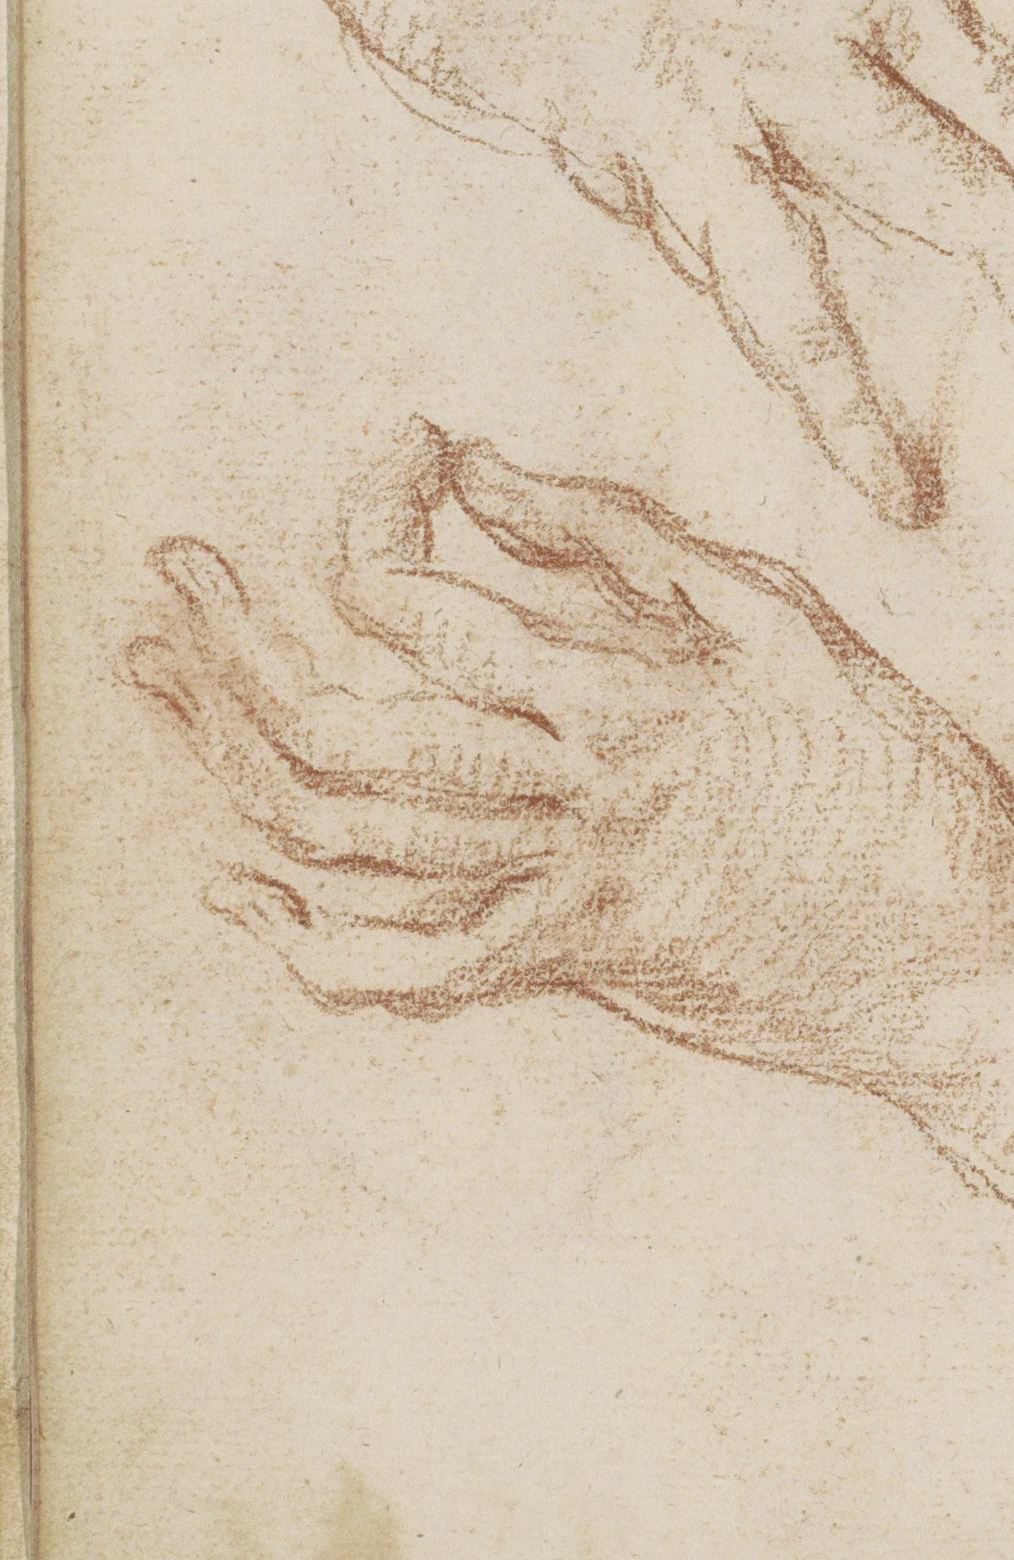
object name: sketchbook leaf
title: Twee handen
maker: petrus johannes van reysschoot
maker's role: draughtsman, print maker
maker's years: 1702-1772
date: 1710-1772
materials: chalk, paper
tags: hand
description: Blad 88 verso uit een schetsboek met 105 bladen.